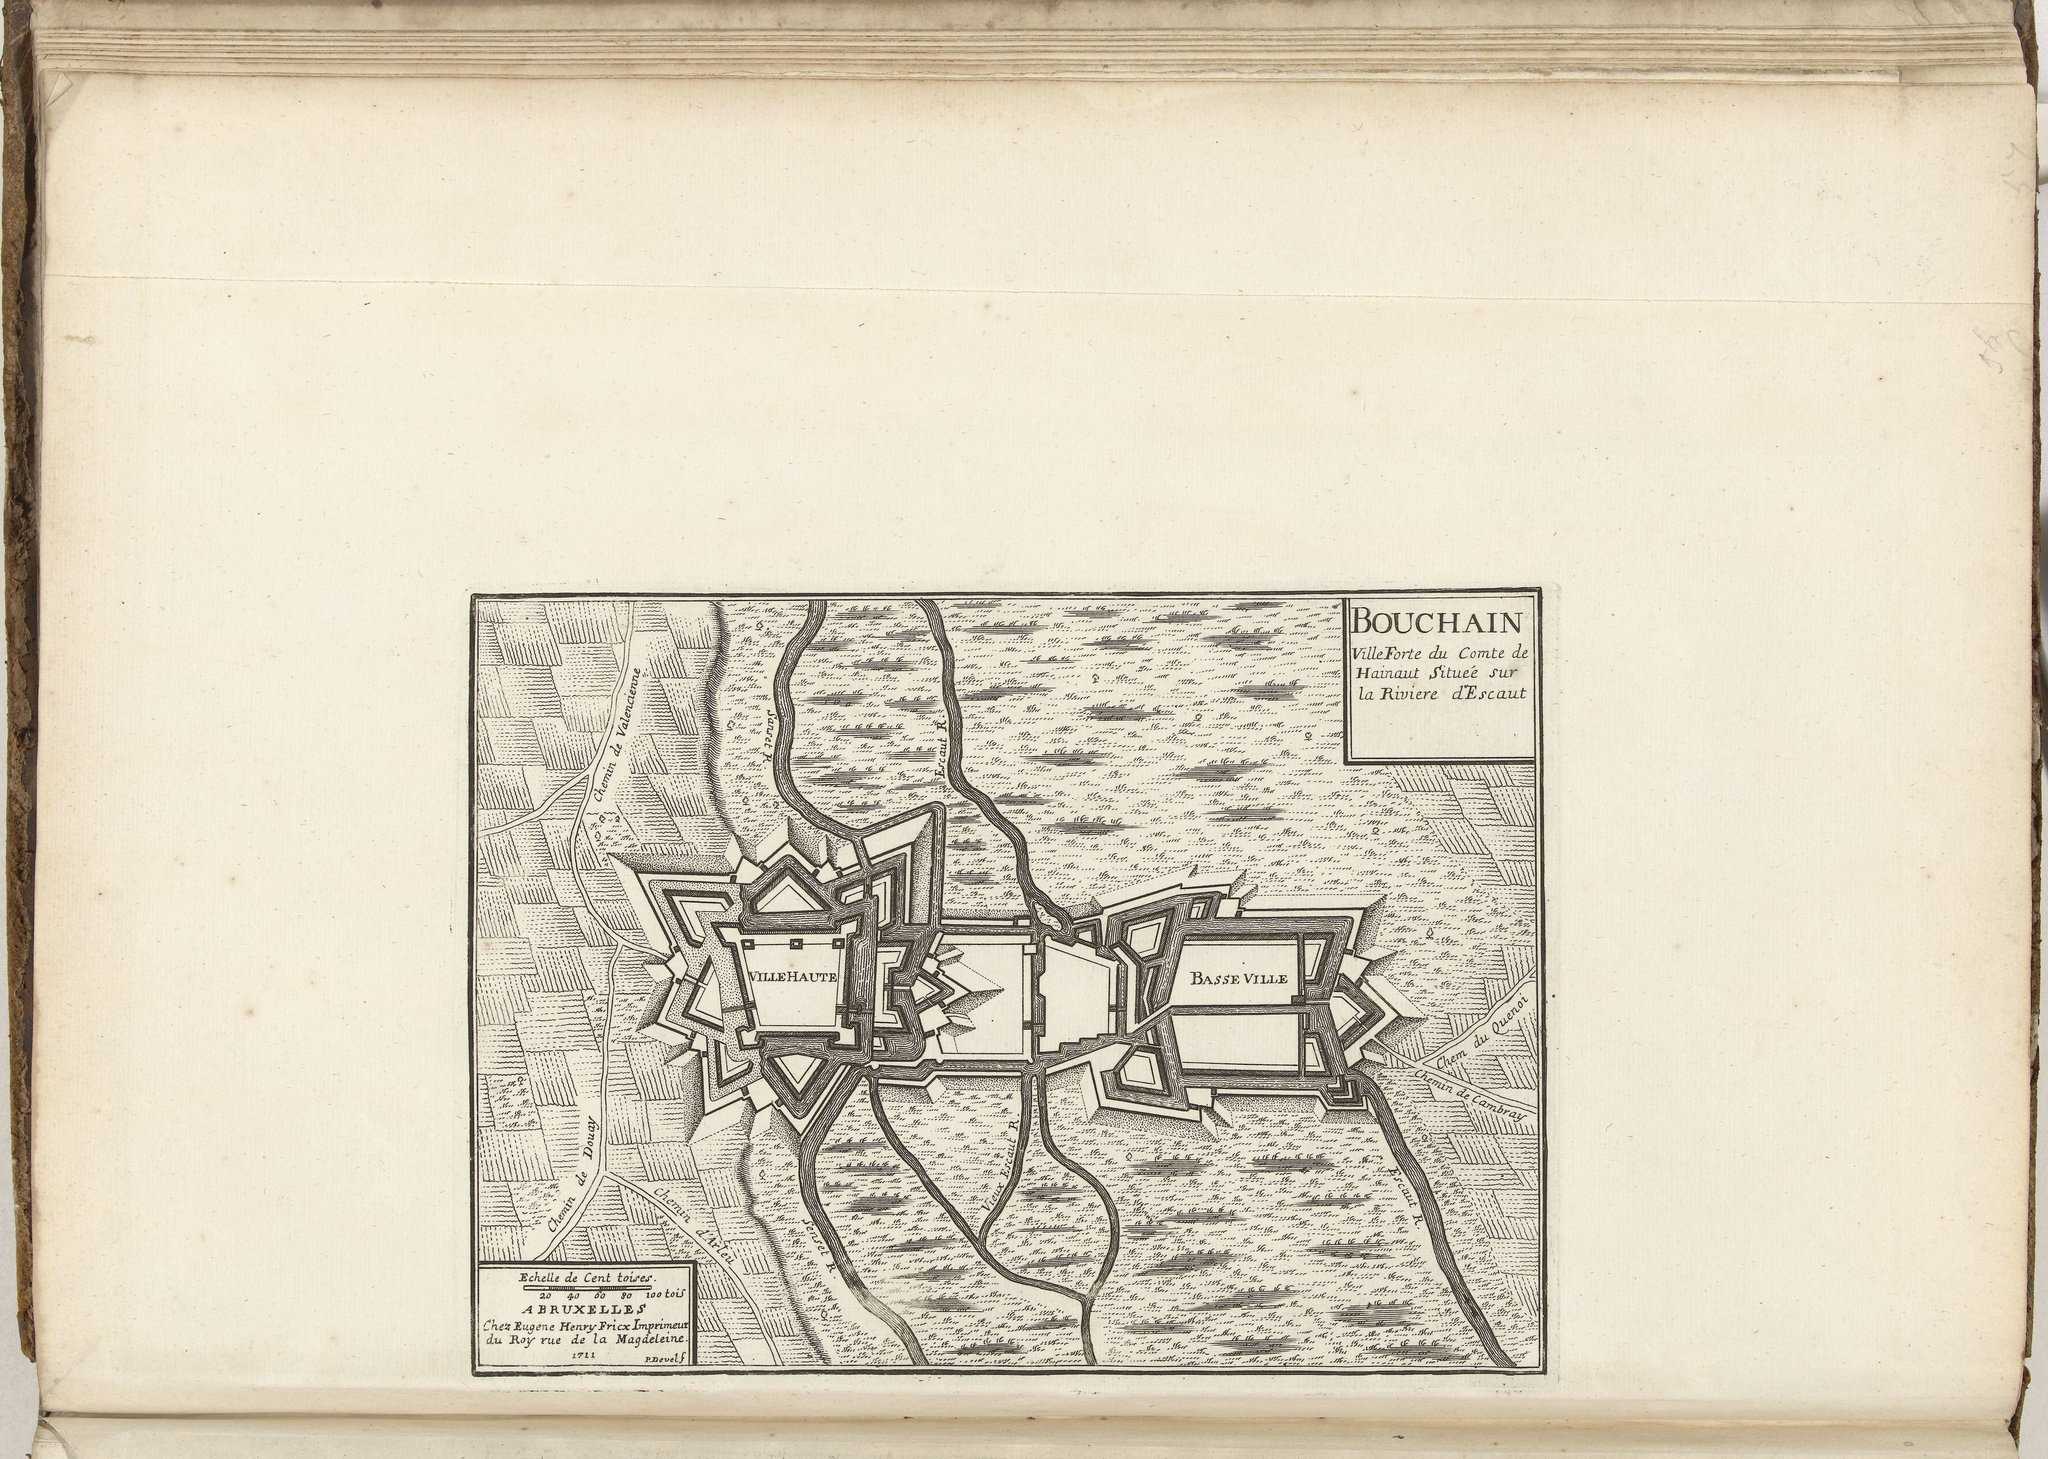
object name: map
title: Plattegrond van Bouchain, 1711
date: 1711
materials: paper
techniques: engraving, etching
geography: brussels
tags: maps of cities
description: Plattegrond van Bouchain, belegerd in 1711 door de Geallieerden. Onderdeel van een gebundelde verzameling van plannen van veldslagen en steden vermaard in de Spaanse Successieoorlog.